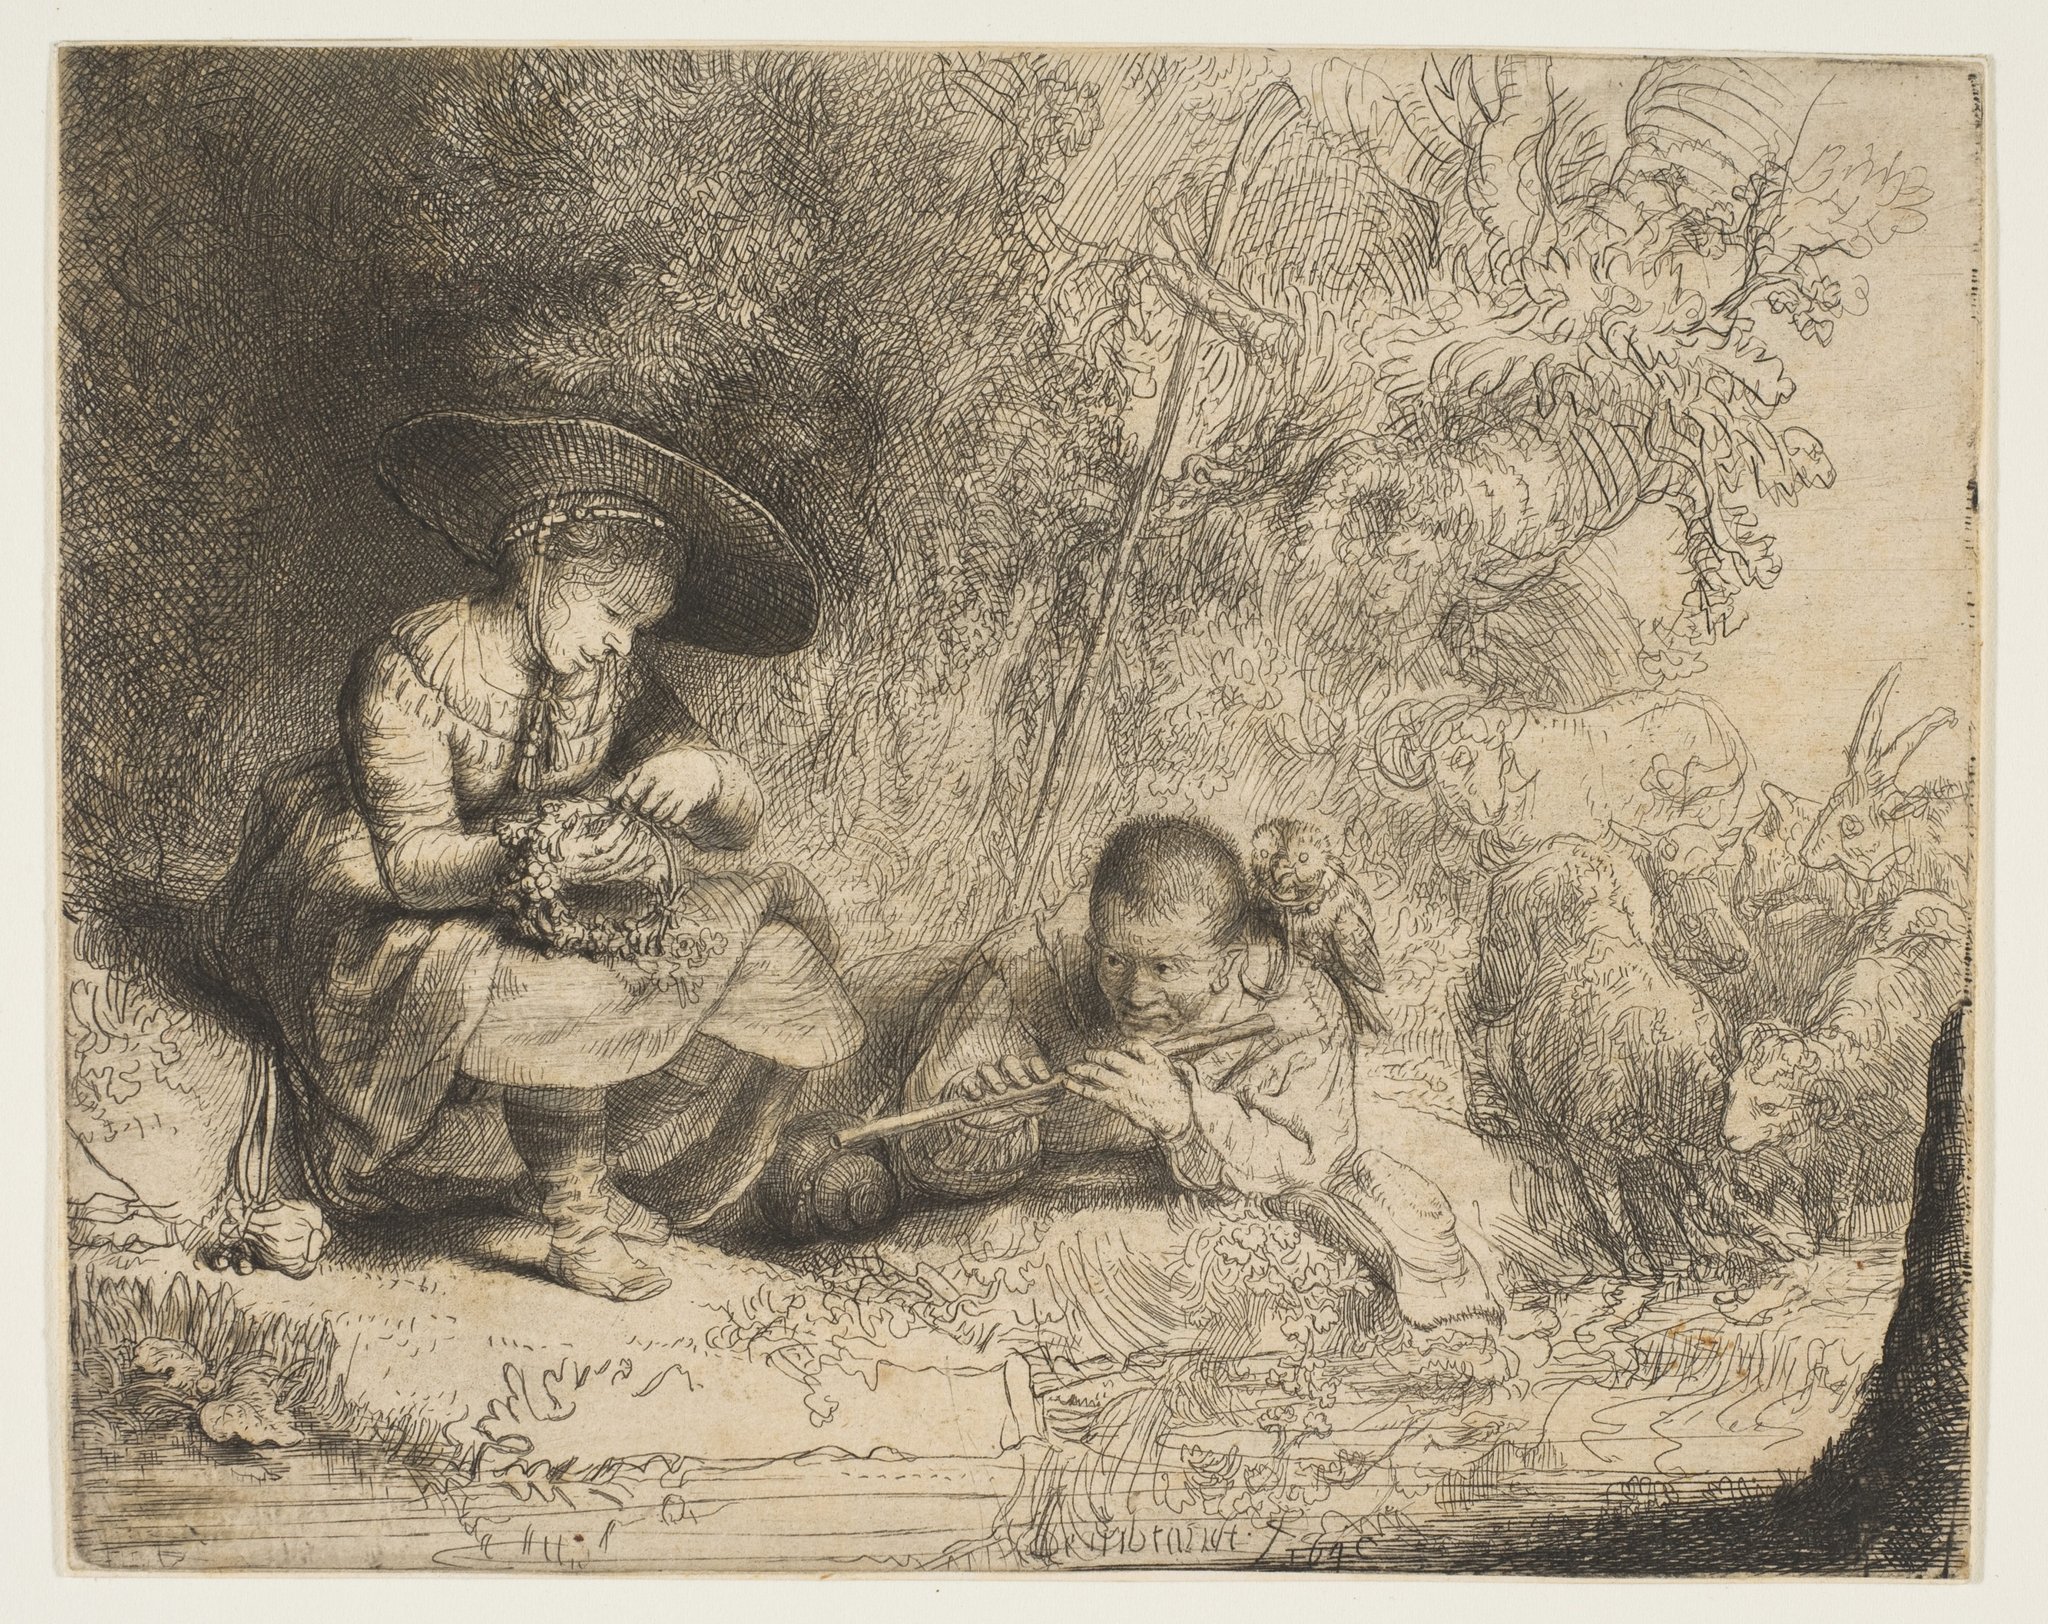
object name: print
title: The Flute Player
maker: rembrandt van rijn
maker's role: artist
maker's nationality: dutch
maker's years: 1606-1669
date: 1642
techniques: drypoint, etching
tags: men,women,flutes,owls,sheep